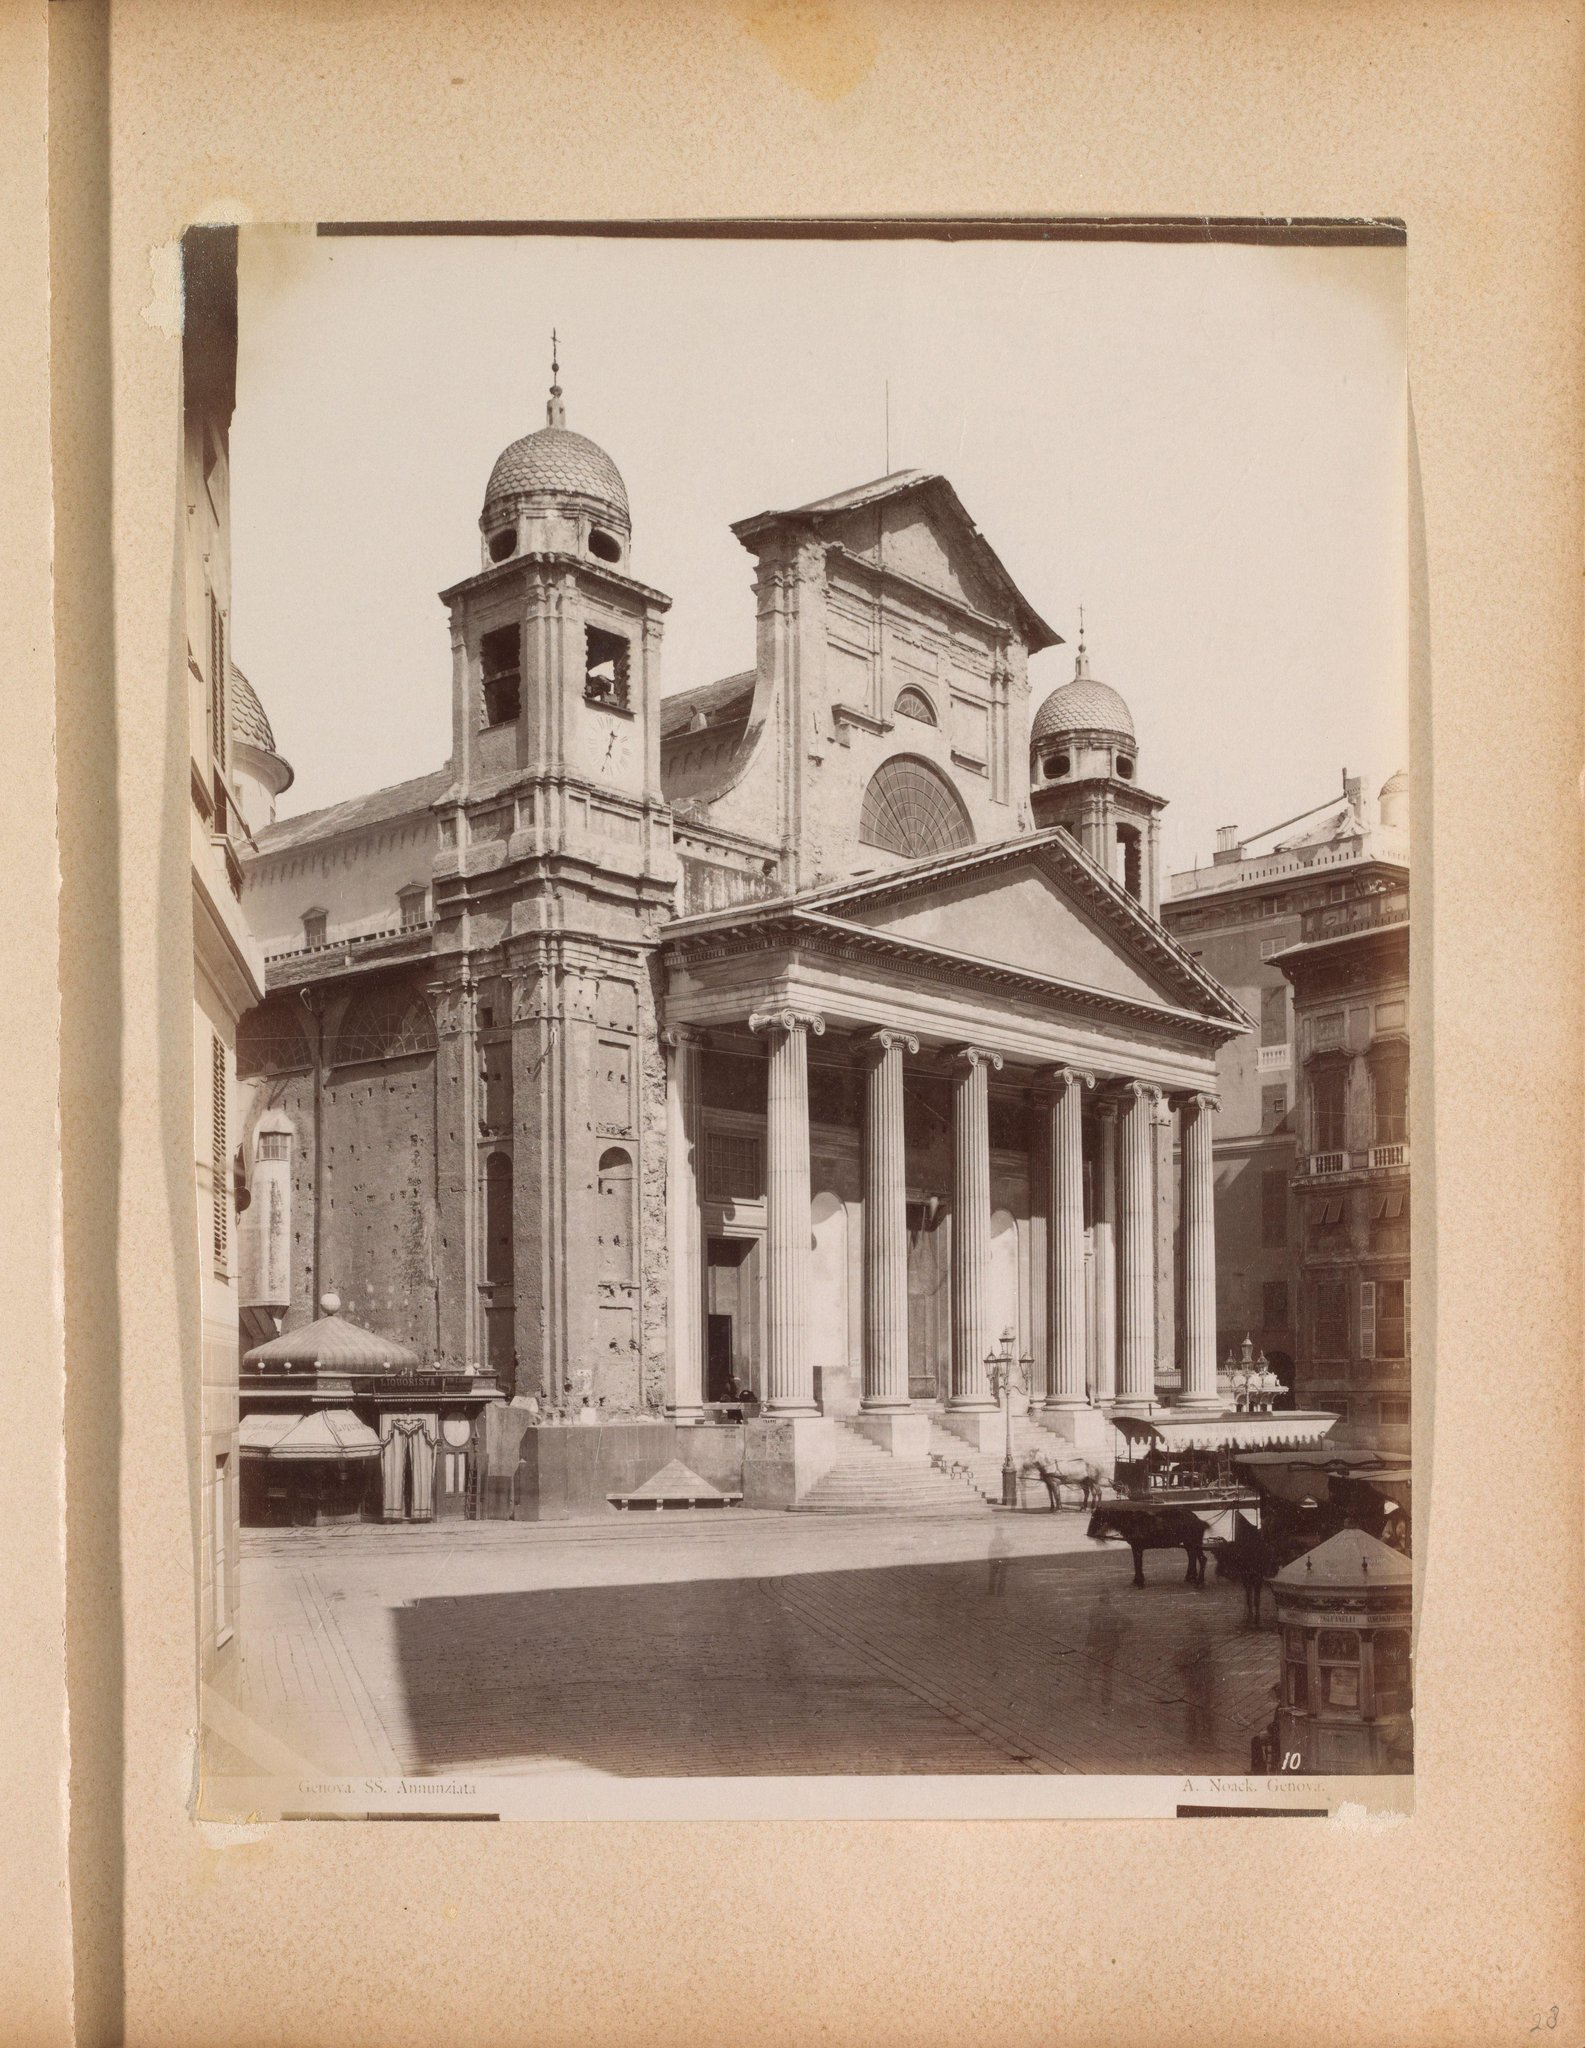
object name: album leaf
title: Exterieur van de Basilica della Santissima Annunziata del Vastato in Genua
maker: alfredo noack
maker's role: fotograaf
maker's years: 1833-1895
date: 1870-1900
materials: paper, photographic support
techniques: albumen print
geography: genoa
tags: church (exterior)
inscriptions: negative number: ‘10’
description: Onderdeel van Reisalbum met foto's van bezienswaardigheden in Italië en Zuid-Frankrijk.